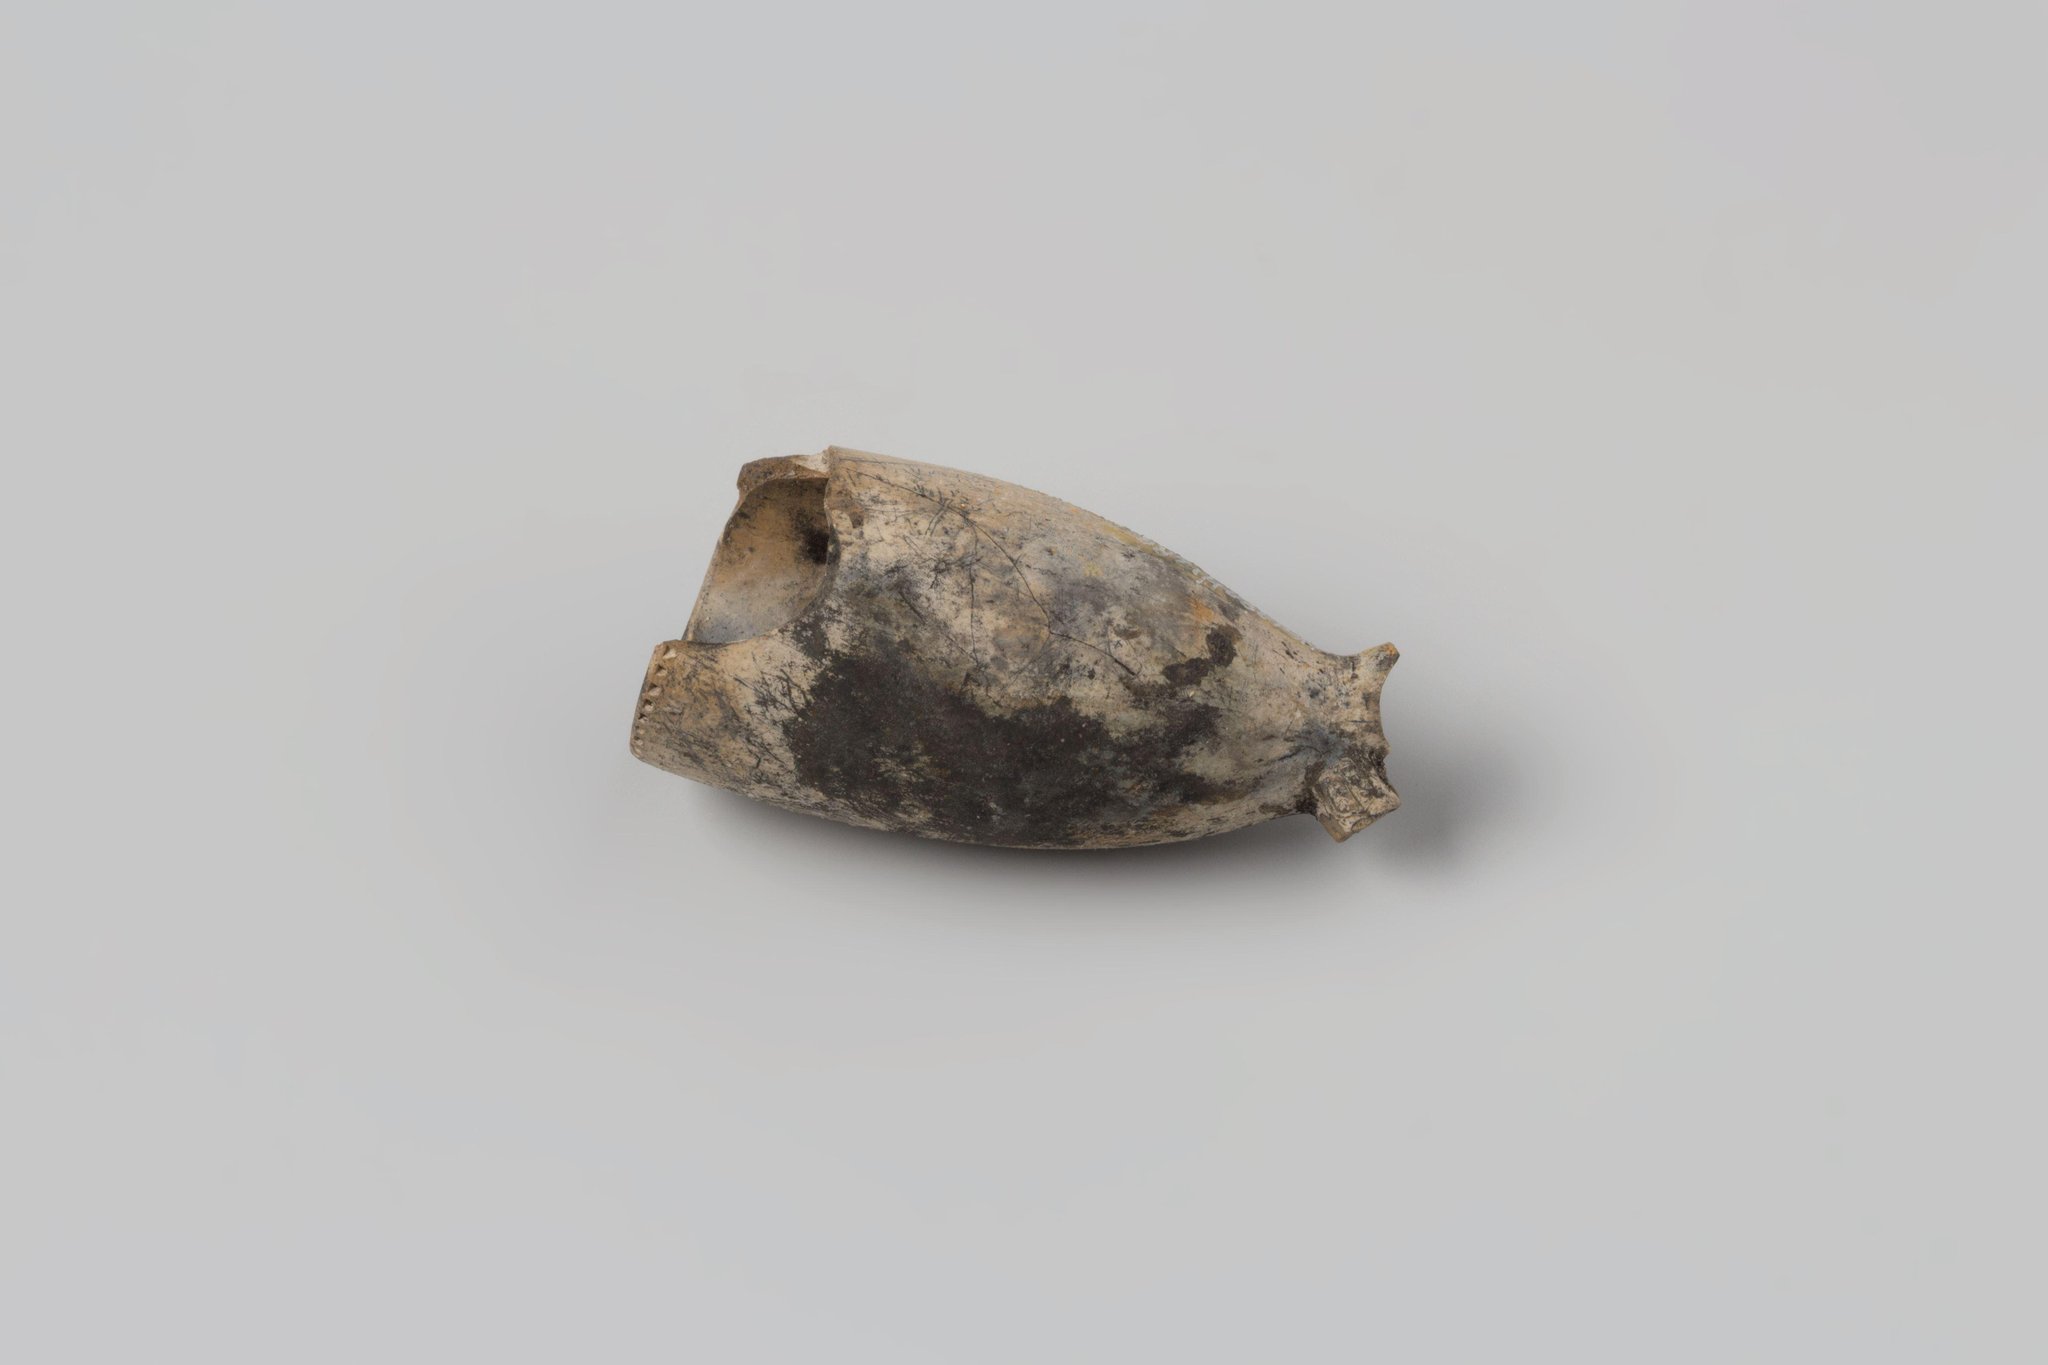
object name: pipe bowl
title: Fragment pijpenkop uit het wrak van de Oost-Indiëvaarder Hollandia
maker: Anonymous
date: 1700-1743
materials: clay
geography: netherlands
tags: verenigde oostindische compagnie, hollandia (schip), annet